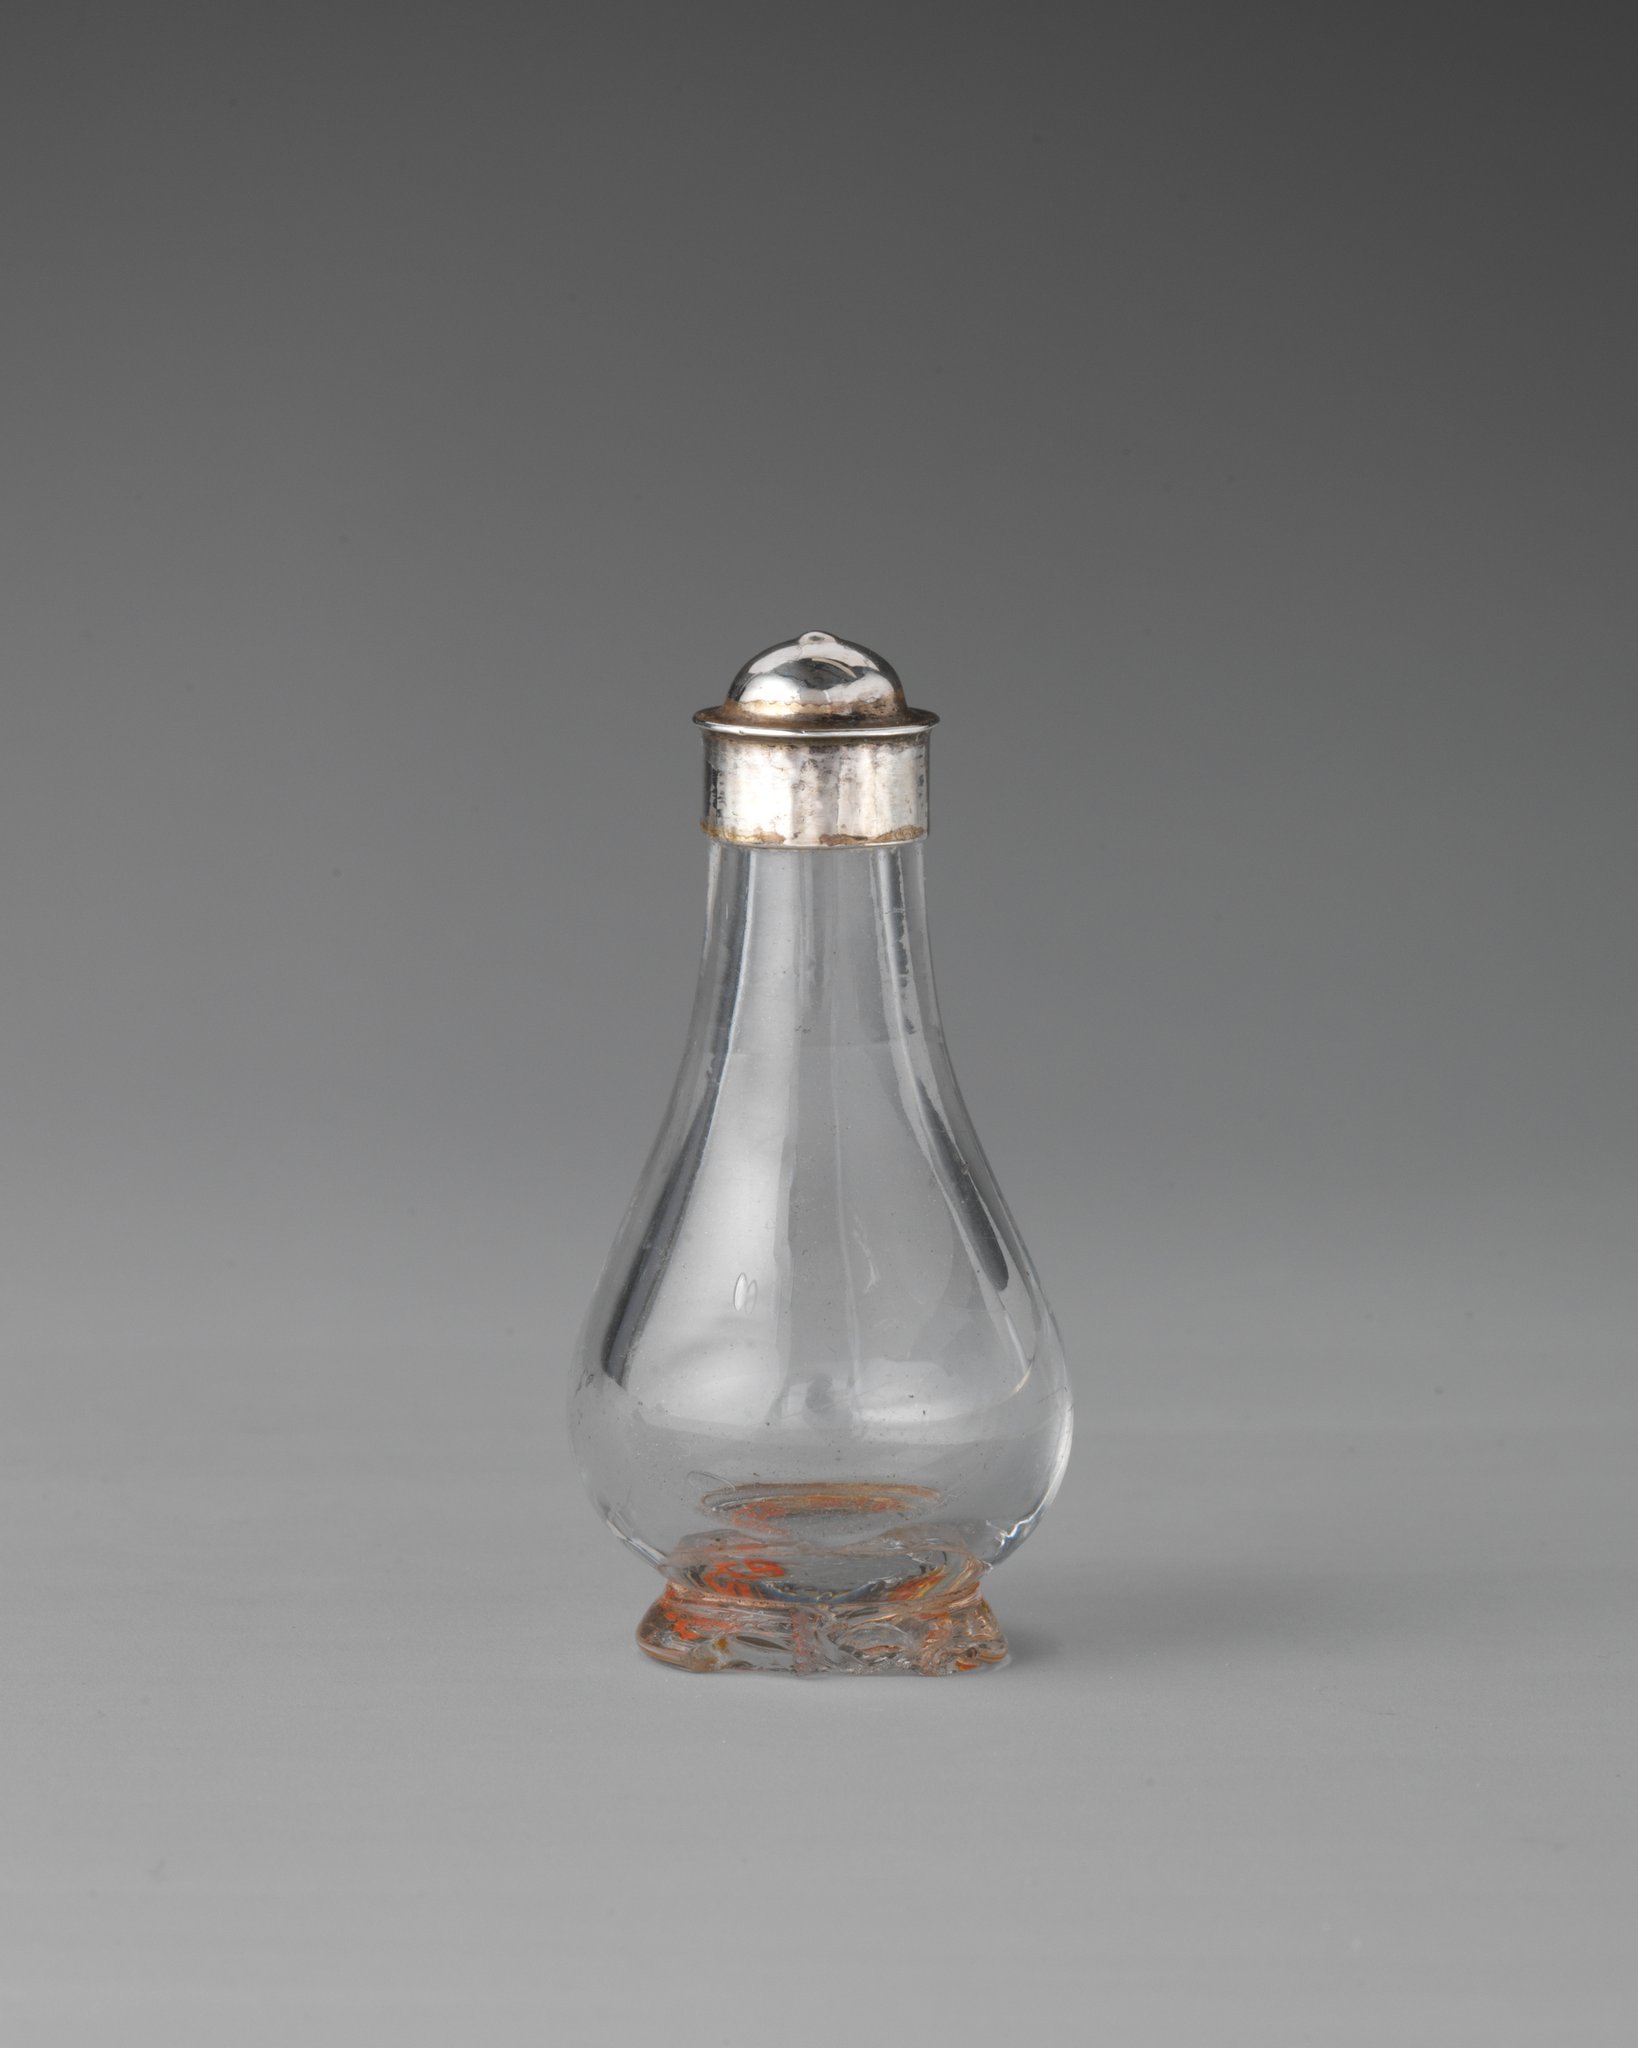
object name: bottle with cover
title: Miniature bottle with cover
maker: david clayton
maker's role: artist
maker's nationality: british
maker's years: 1659-1719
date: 1701-1800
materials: glass, silver